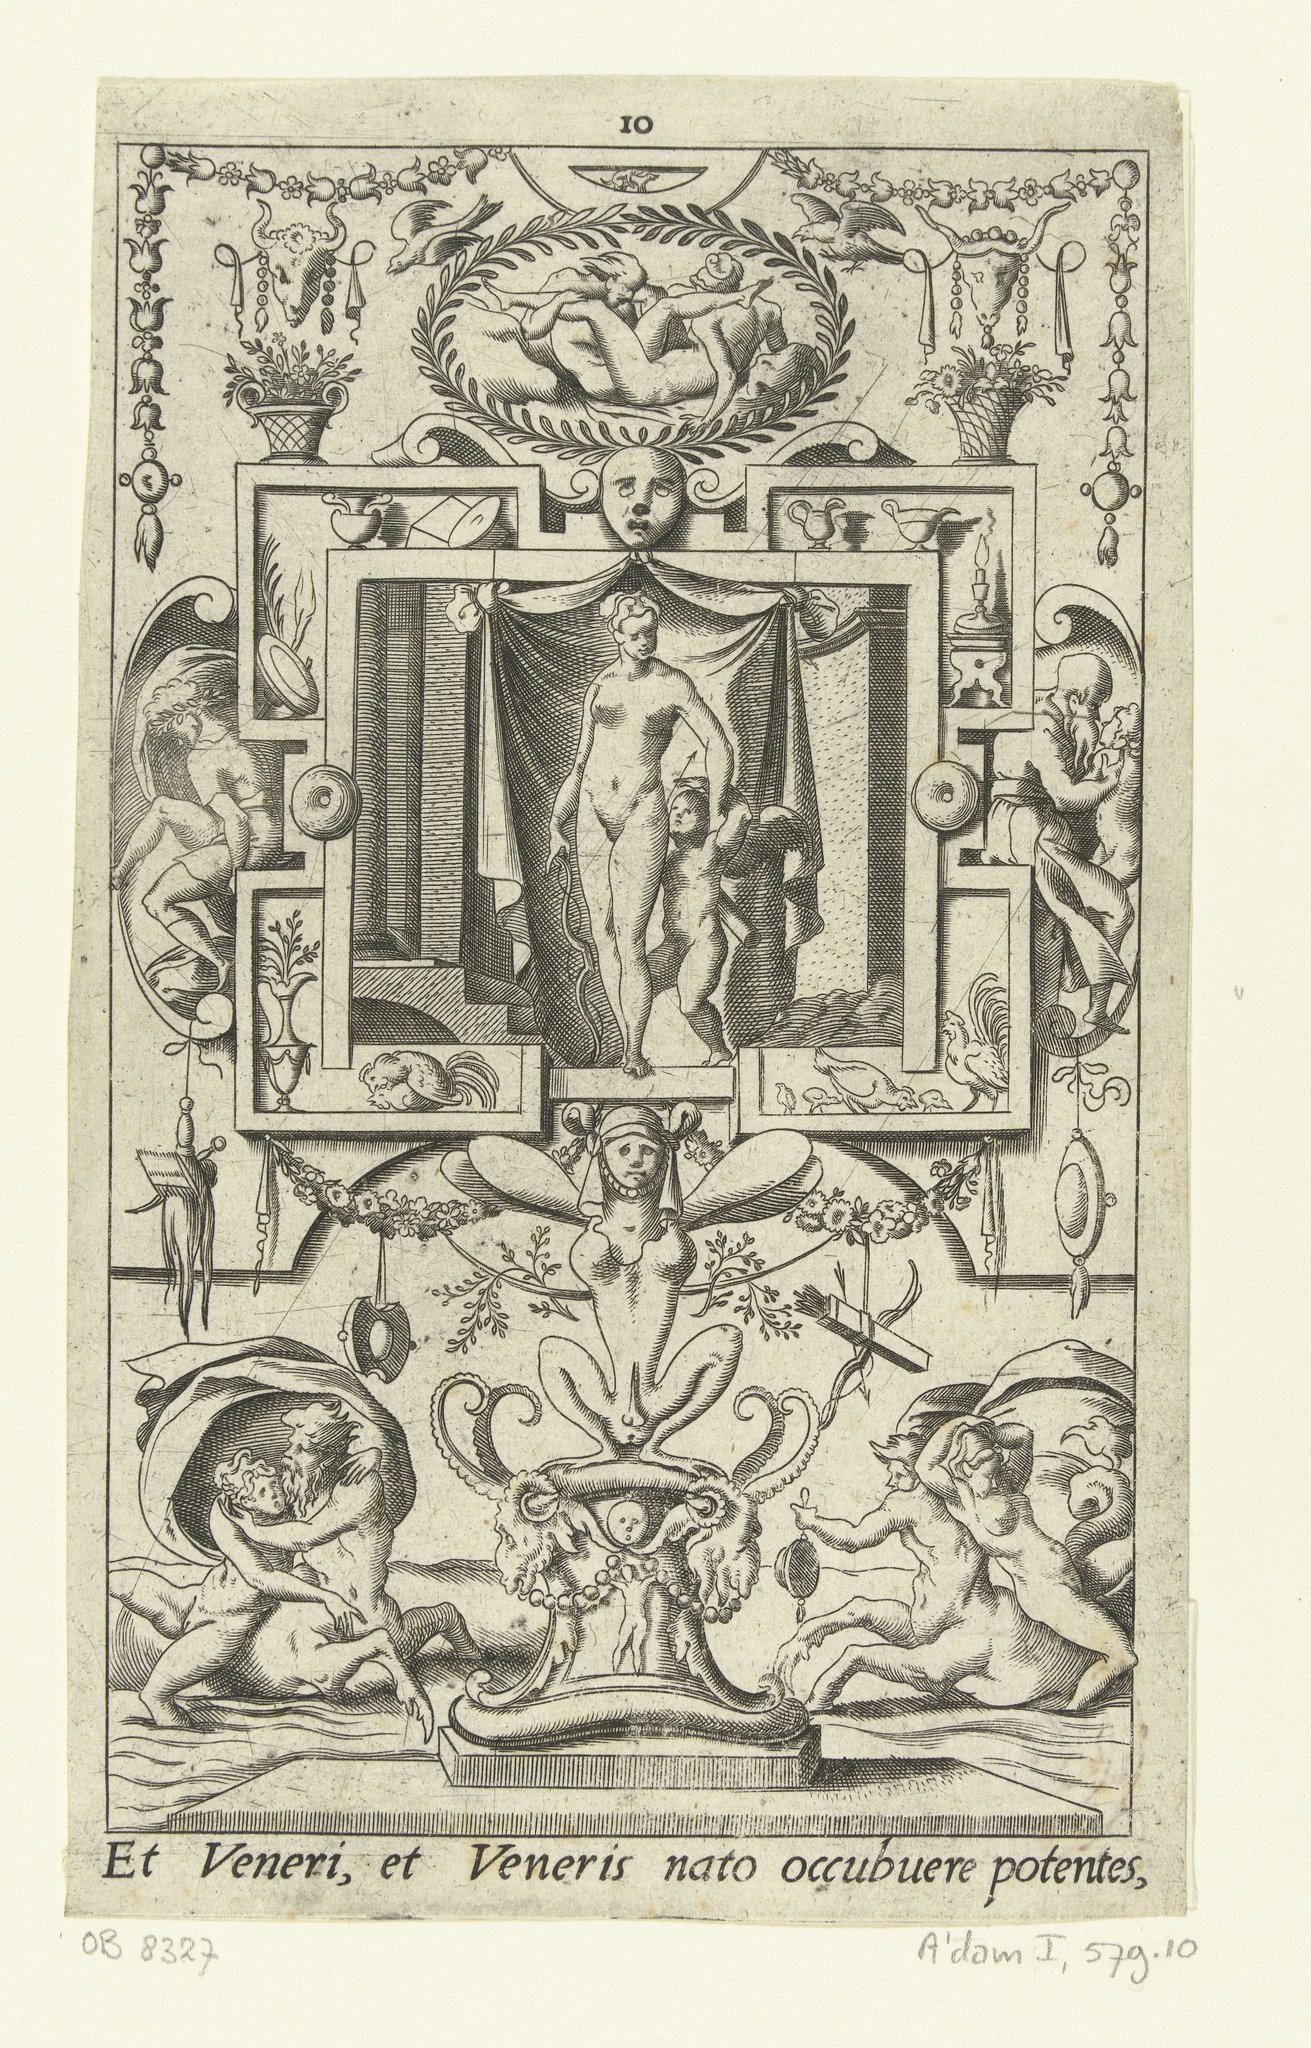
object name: print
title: Venus en Amor in een rechthoekige omlijsting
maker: rené boyvin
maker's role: print maker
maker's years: 1525-1598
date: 1551-1580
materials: paper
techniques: engraving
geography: france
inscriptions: collector's mark: Lugt 240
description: Onderaan staat een Latijnse tekst. Uit serie van 16 deels genummerde bladen met vlakdecoraties van goden en godinnen in een omlijsting van grotesken met fantastische wezens, dieren, guirlandes en mascarons.